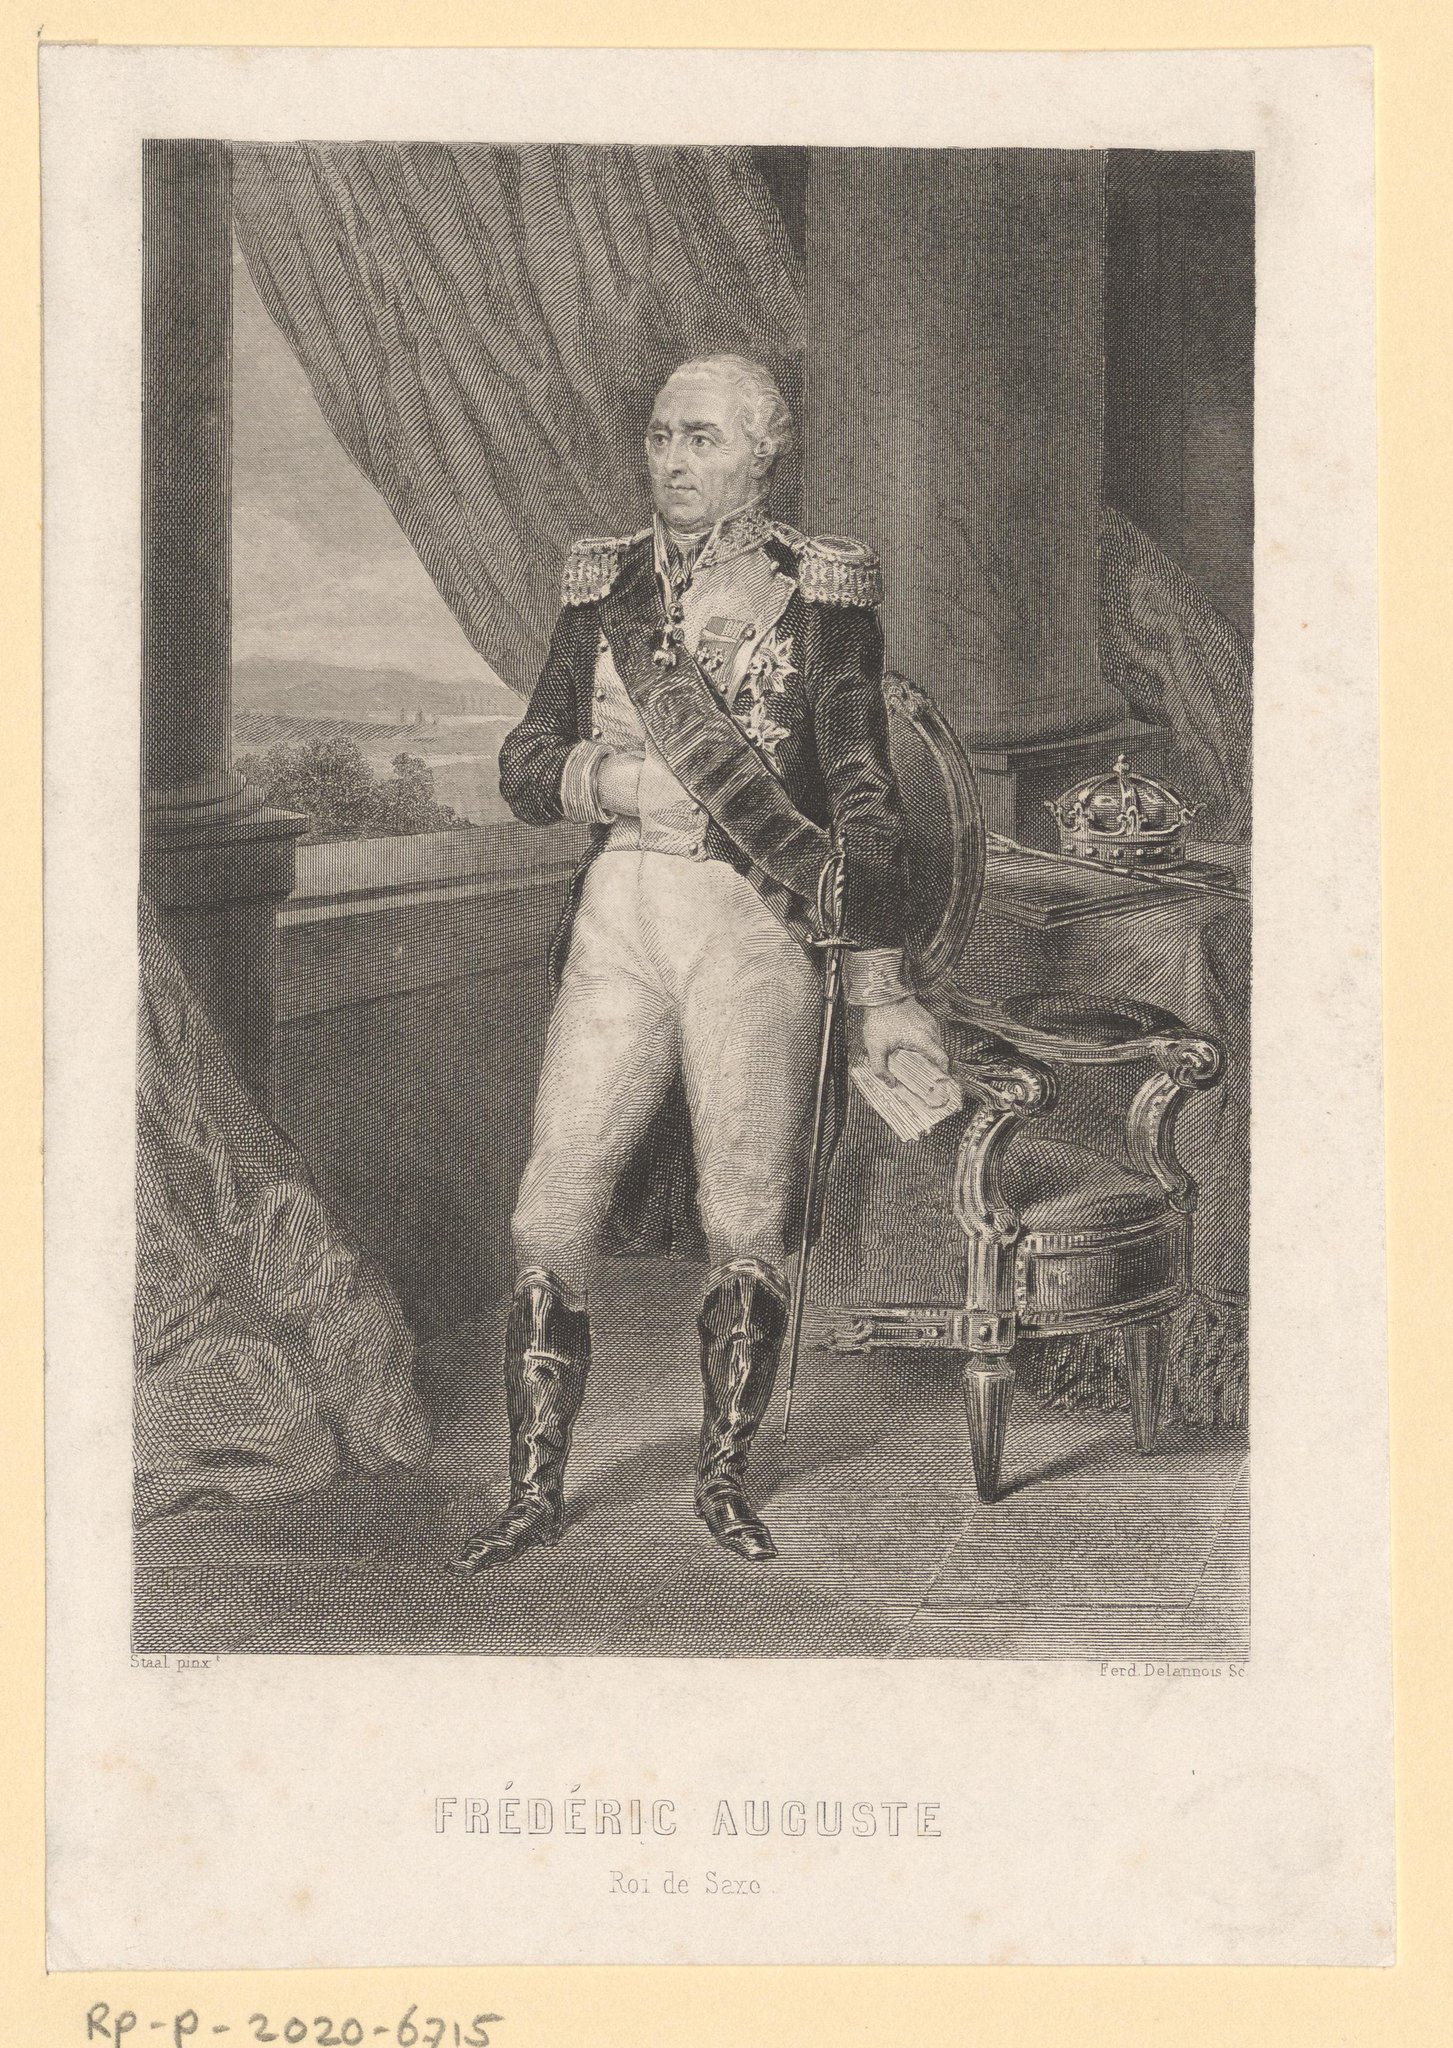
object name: print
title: Portret van Frederik August I van Saksen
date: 1832-1887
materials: paper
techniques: etching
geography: france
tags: frederik august i (koning van saksen), crown (symbol of sovereignty), historical persons, (military) uniforms, king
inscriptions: number: ‘No 451’